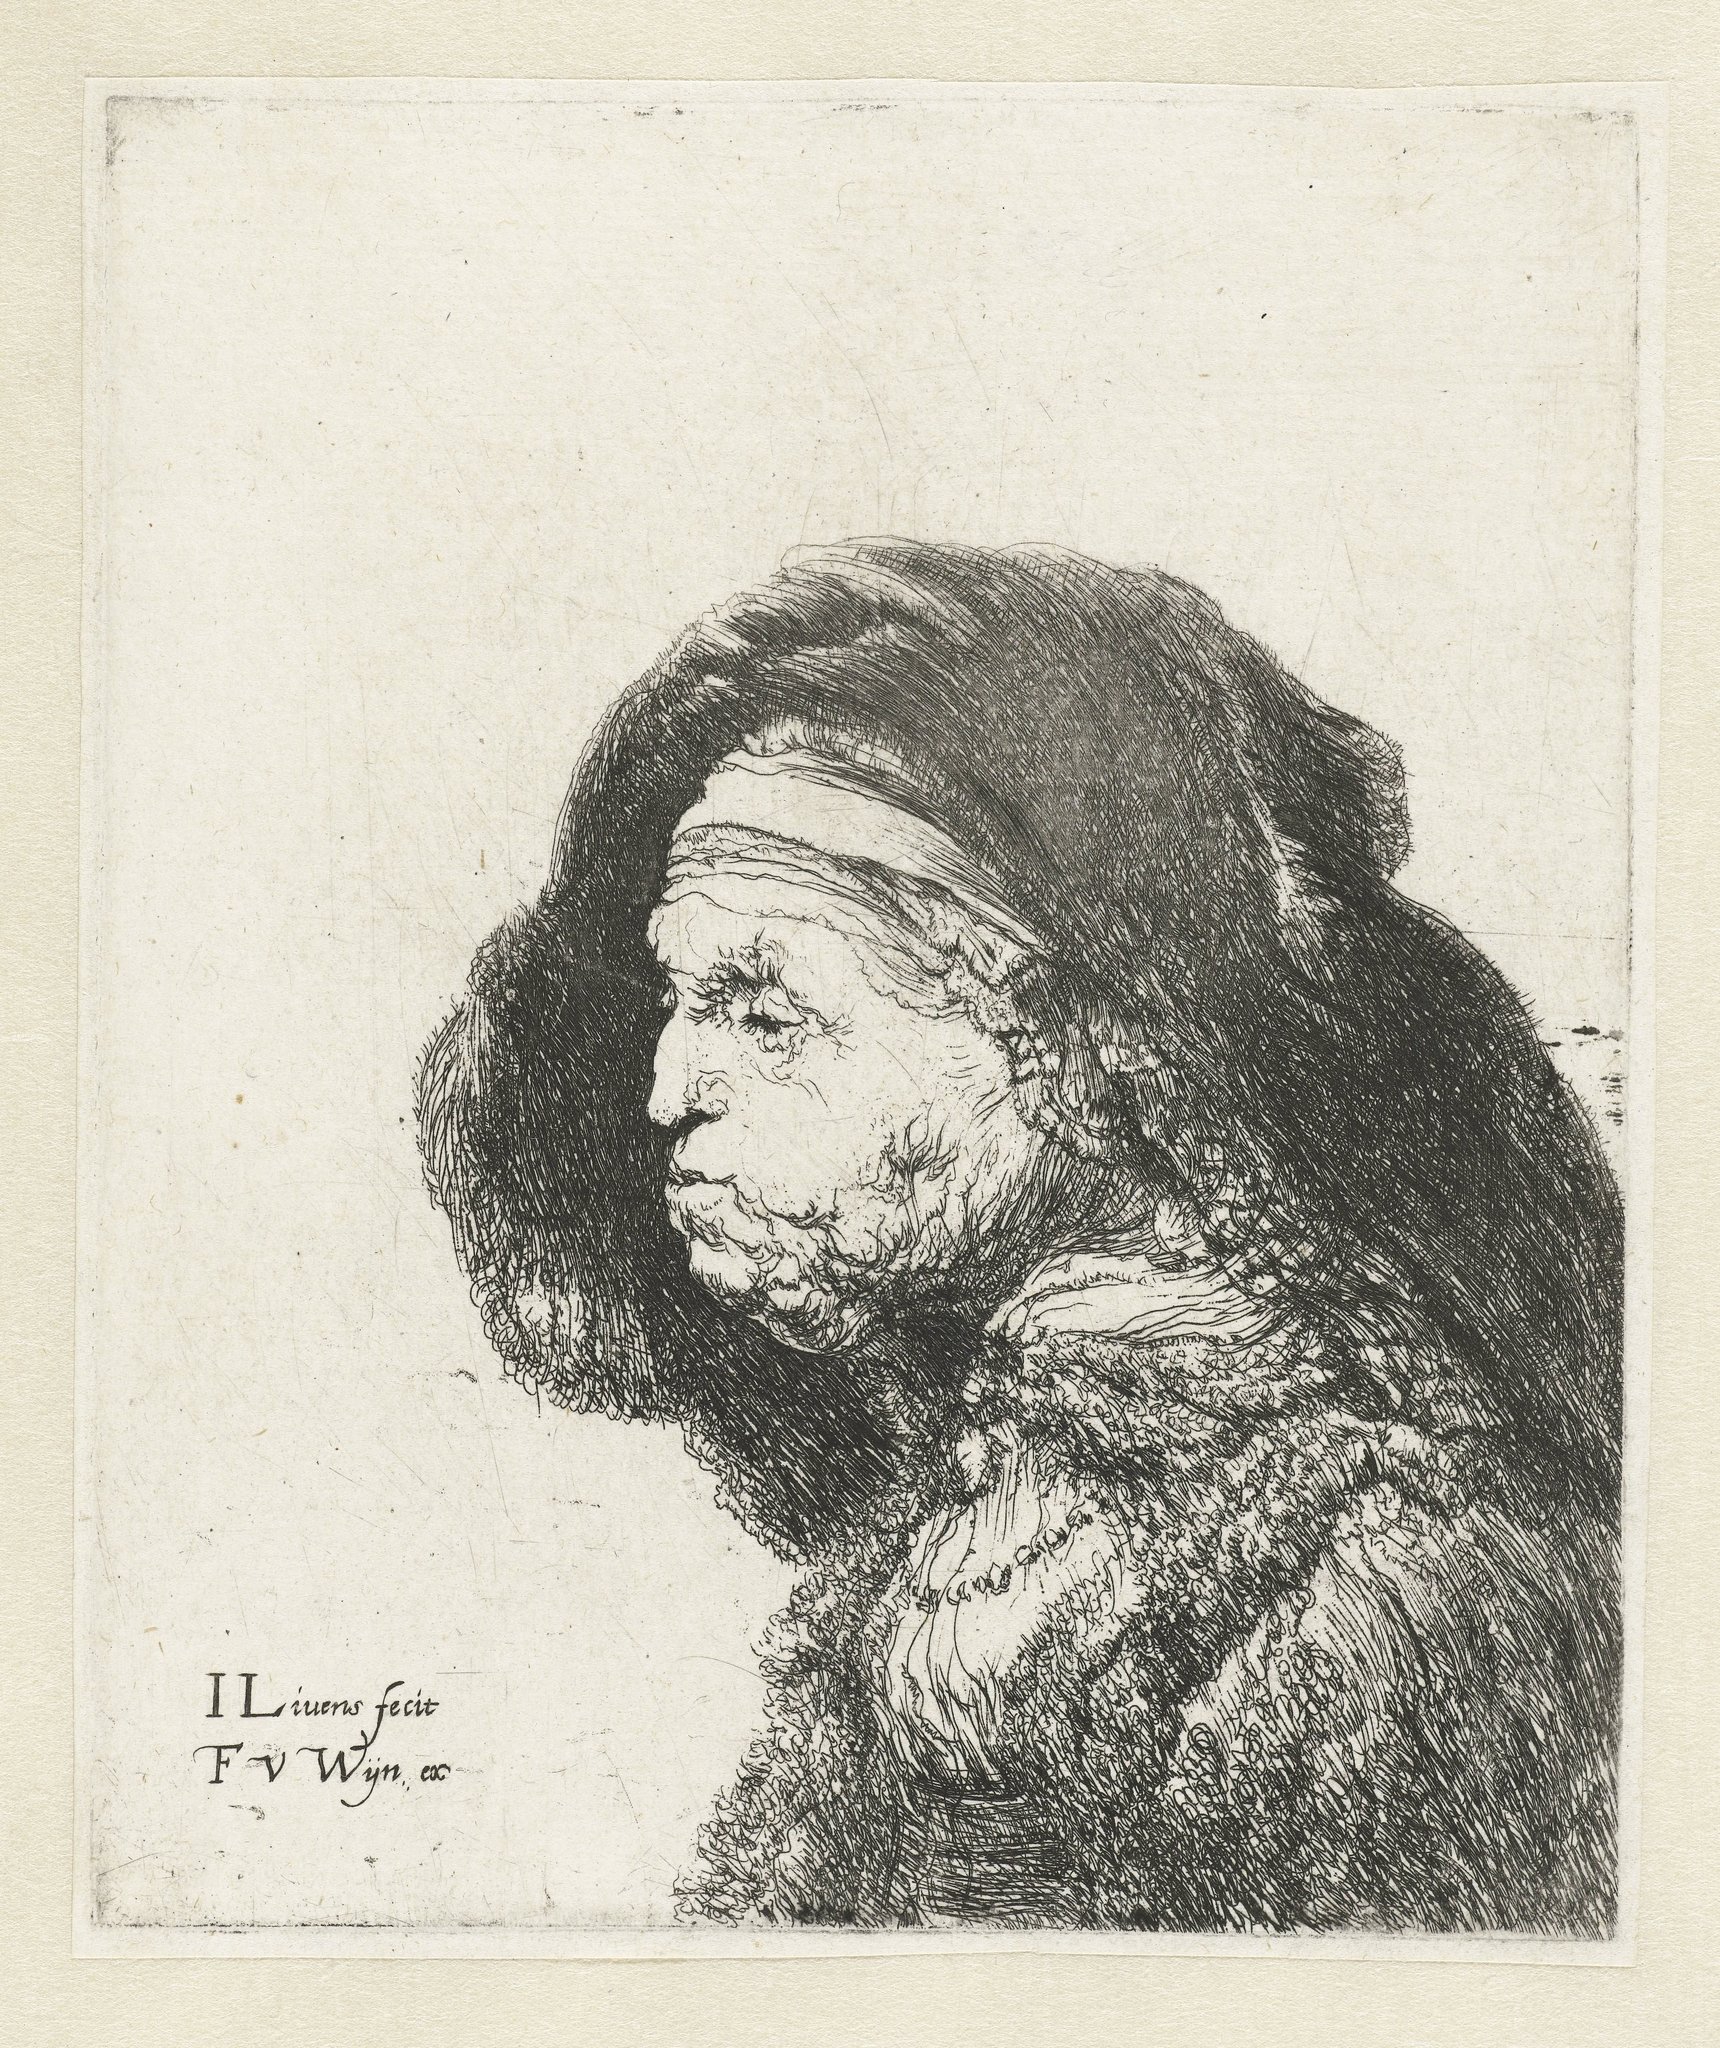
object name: print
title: Borstbeeld van een oude vrouw met mantel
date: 1625-1674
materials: paper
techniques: etching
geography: antwerp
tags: old woman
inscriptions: collector's mark: Lugt 240